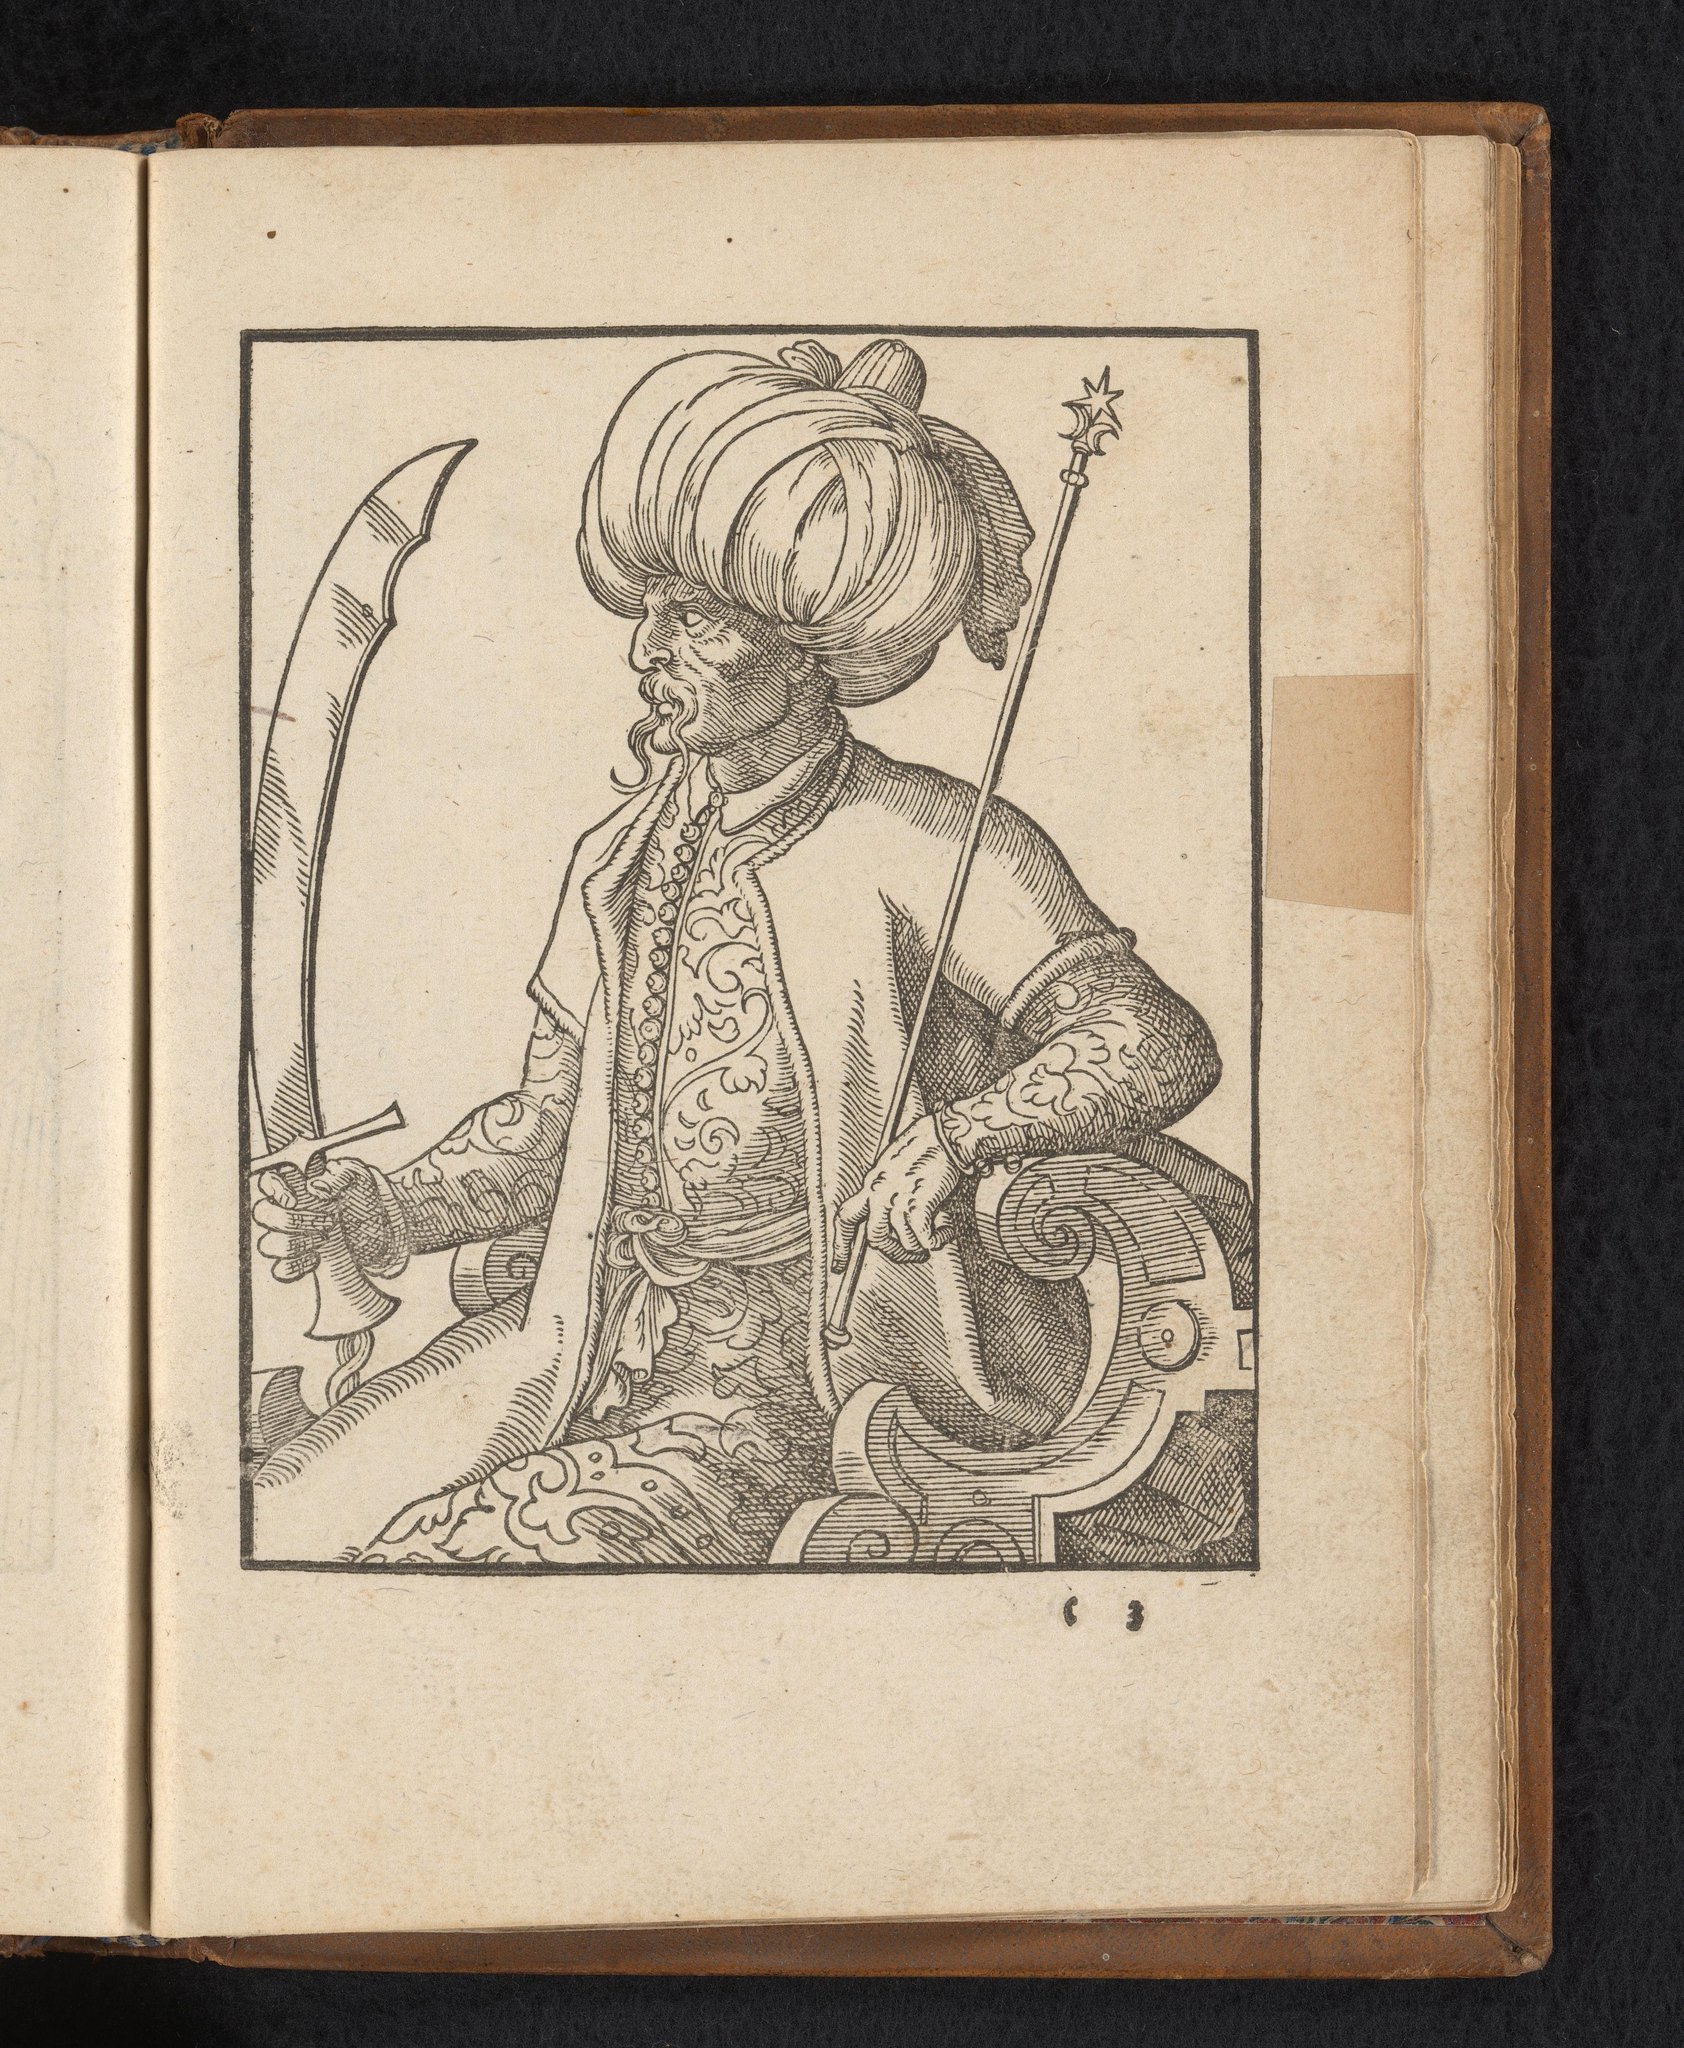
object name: print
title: Ottomaanse veldheer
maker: Anonymous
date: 1578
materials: paper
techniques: woodcut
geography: nuremberg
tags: asiatic races and peoples: turks, head-gear: turban, the soldier; the soldier's life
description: Een Ottomaanse veldheer, zittend naar links, in de handen een kromzwaard en een scepter, op het hoofd een tulband. Onderdeel van het modelboek Enchiridion artis pingendi, fingendi & sculpendi met 108 figuren bedoeld voor beginnende schilders, beeldhouwers en prentmakers.